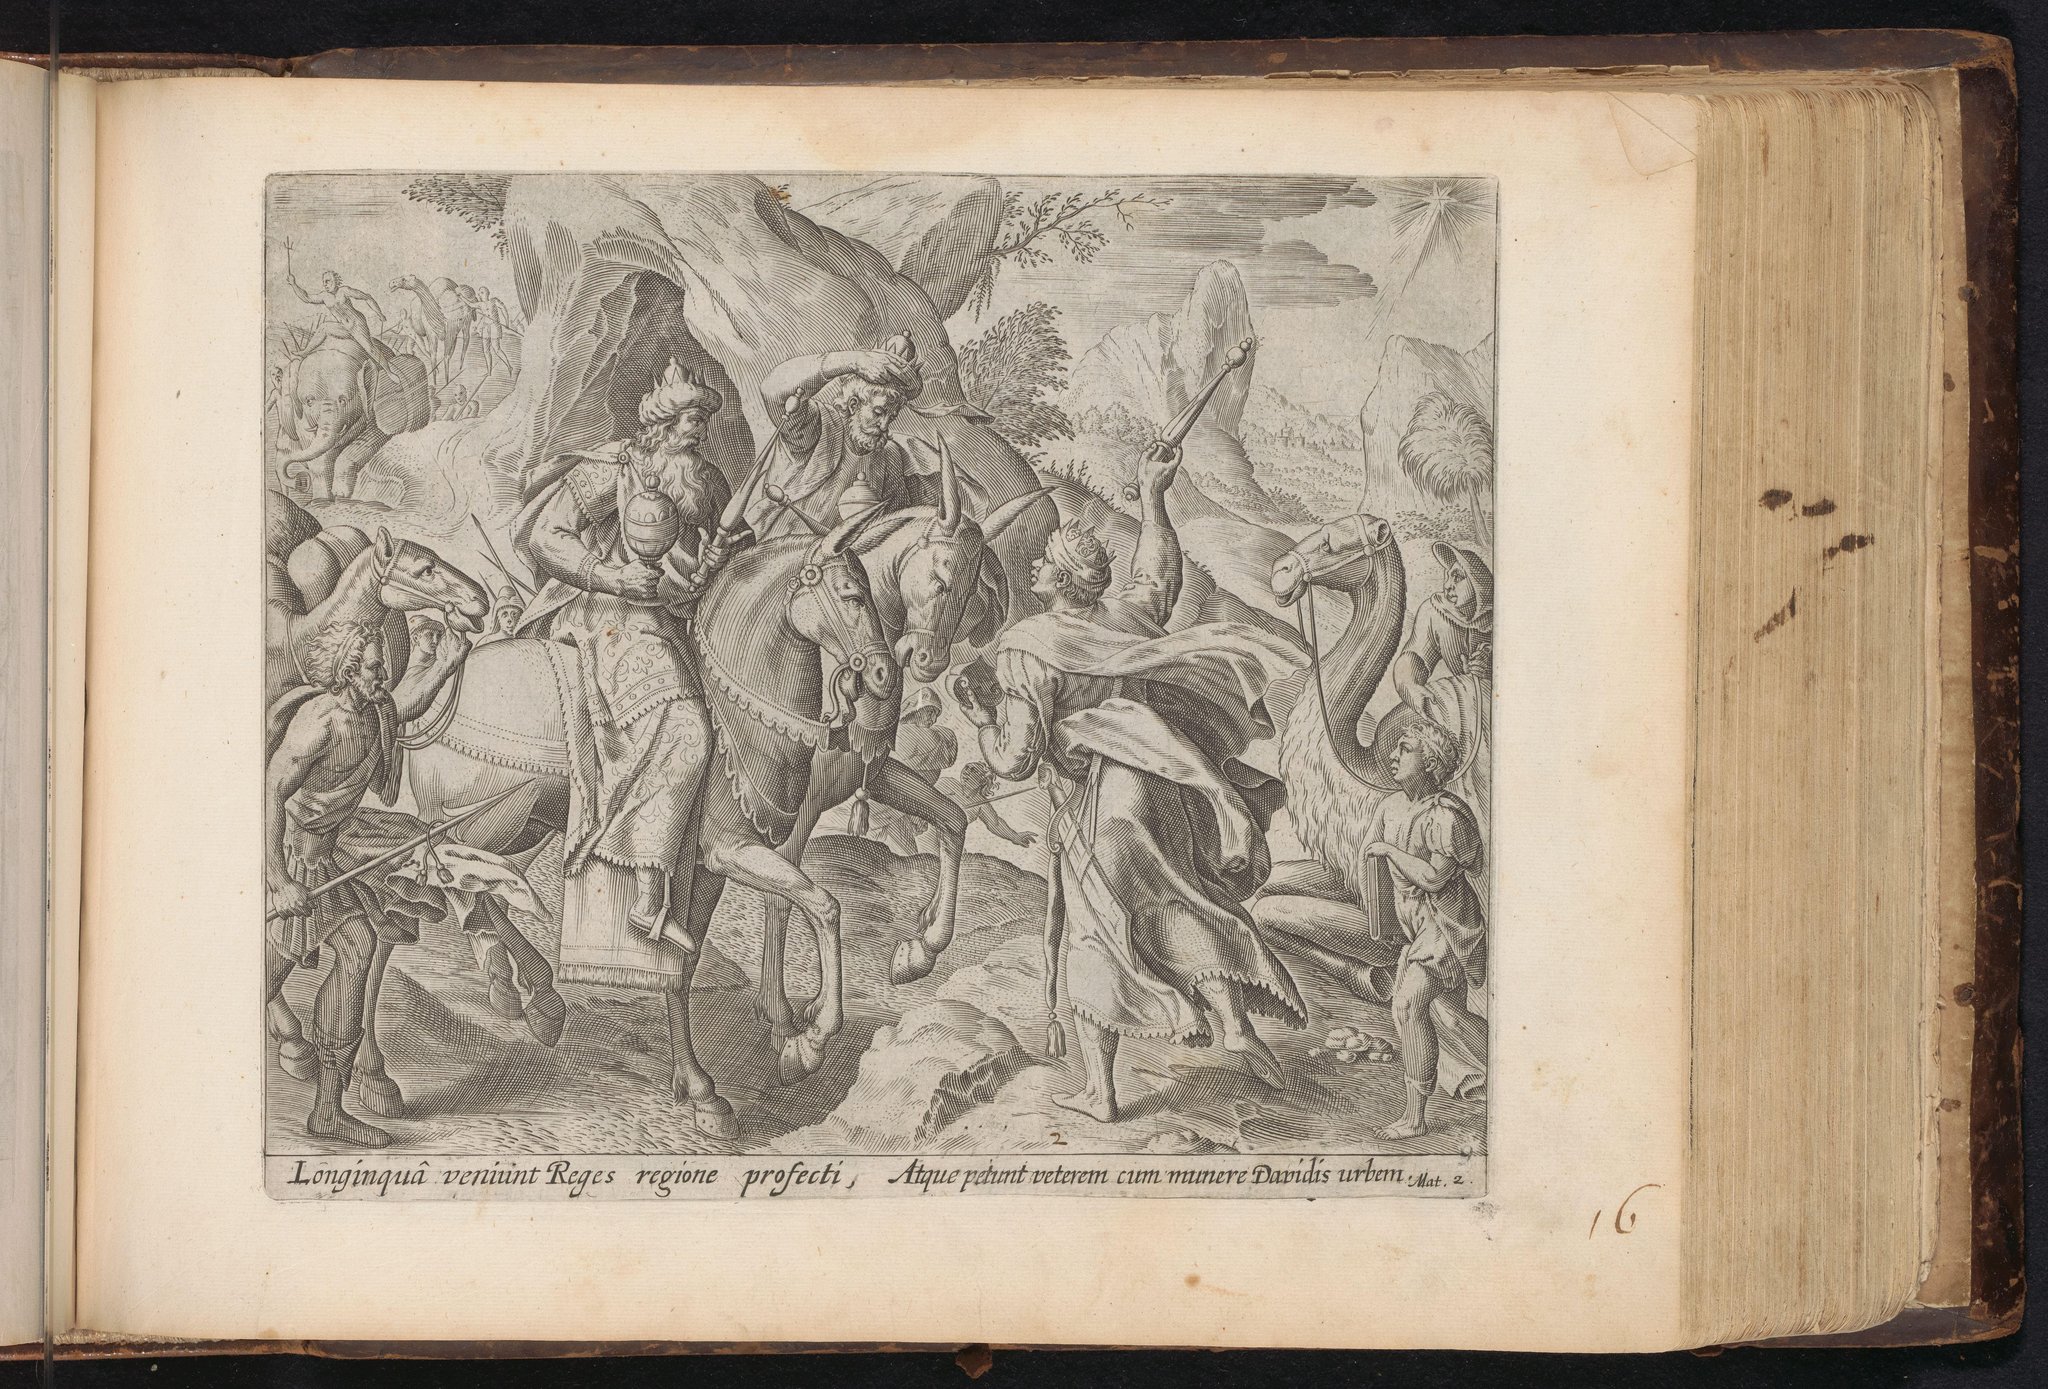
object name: album leaf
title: Den Grooten Figuer-Bibel (...)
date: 1572-1576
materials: paper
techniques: engraving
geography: alkmaar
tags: journey of the three wise men to jerusalem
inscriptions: number: ‘16’, serial number: ‘2’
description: De drie koningen ontmoeten elkaar op een kruispunt en volgen samen de ster van Betlehem. De zwarte koning wijst met zijn scepter op de ster. Onder de voorstelling een verwijzing in het Latijn naar de Bijbeltekst in Mat. 2. Deze prent maakt deel uit van een album.